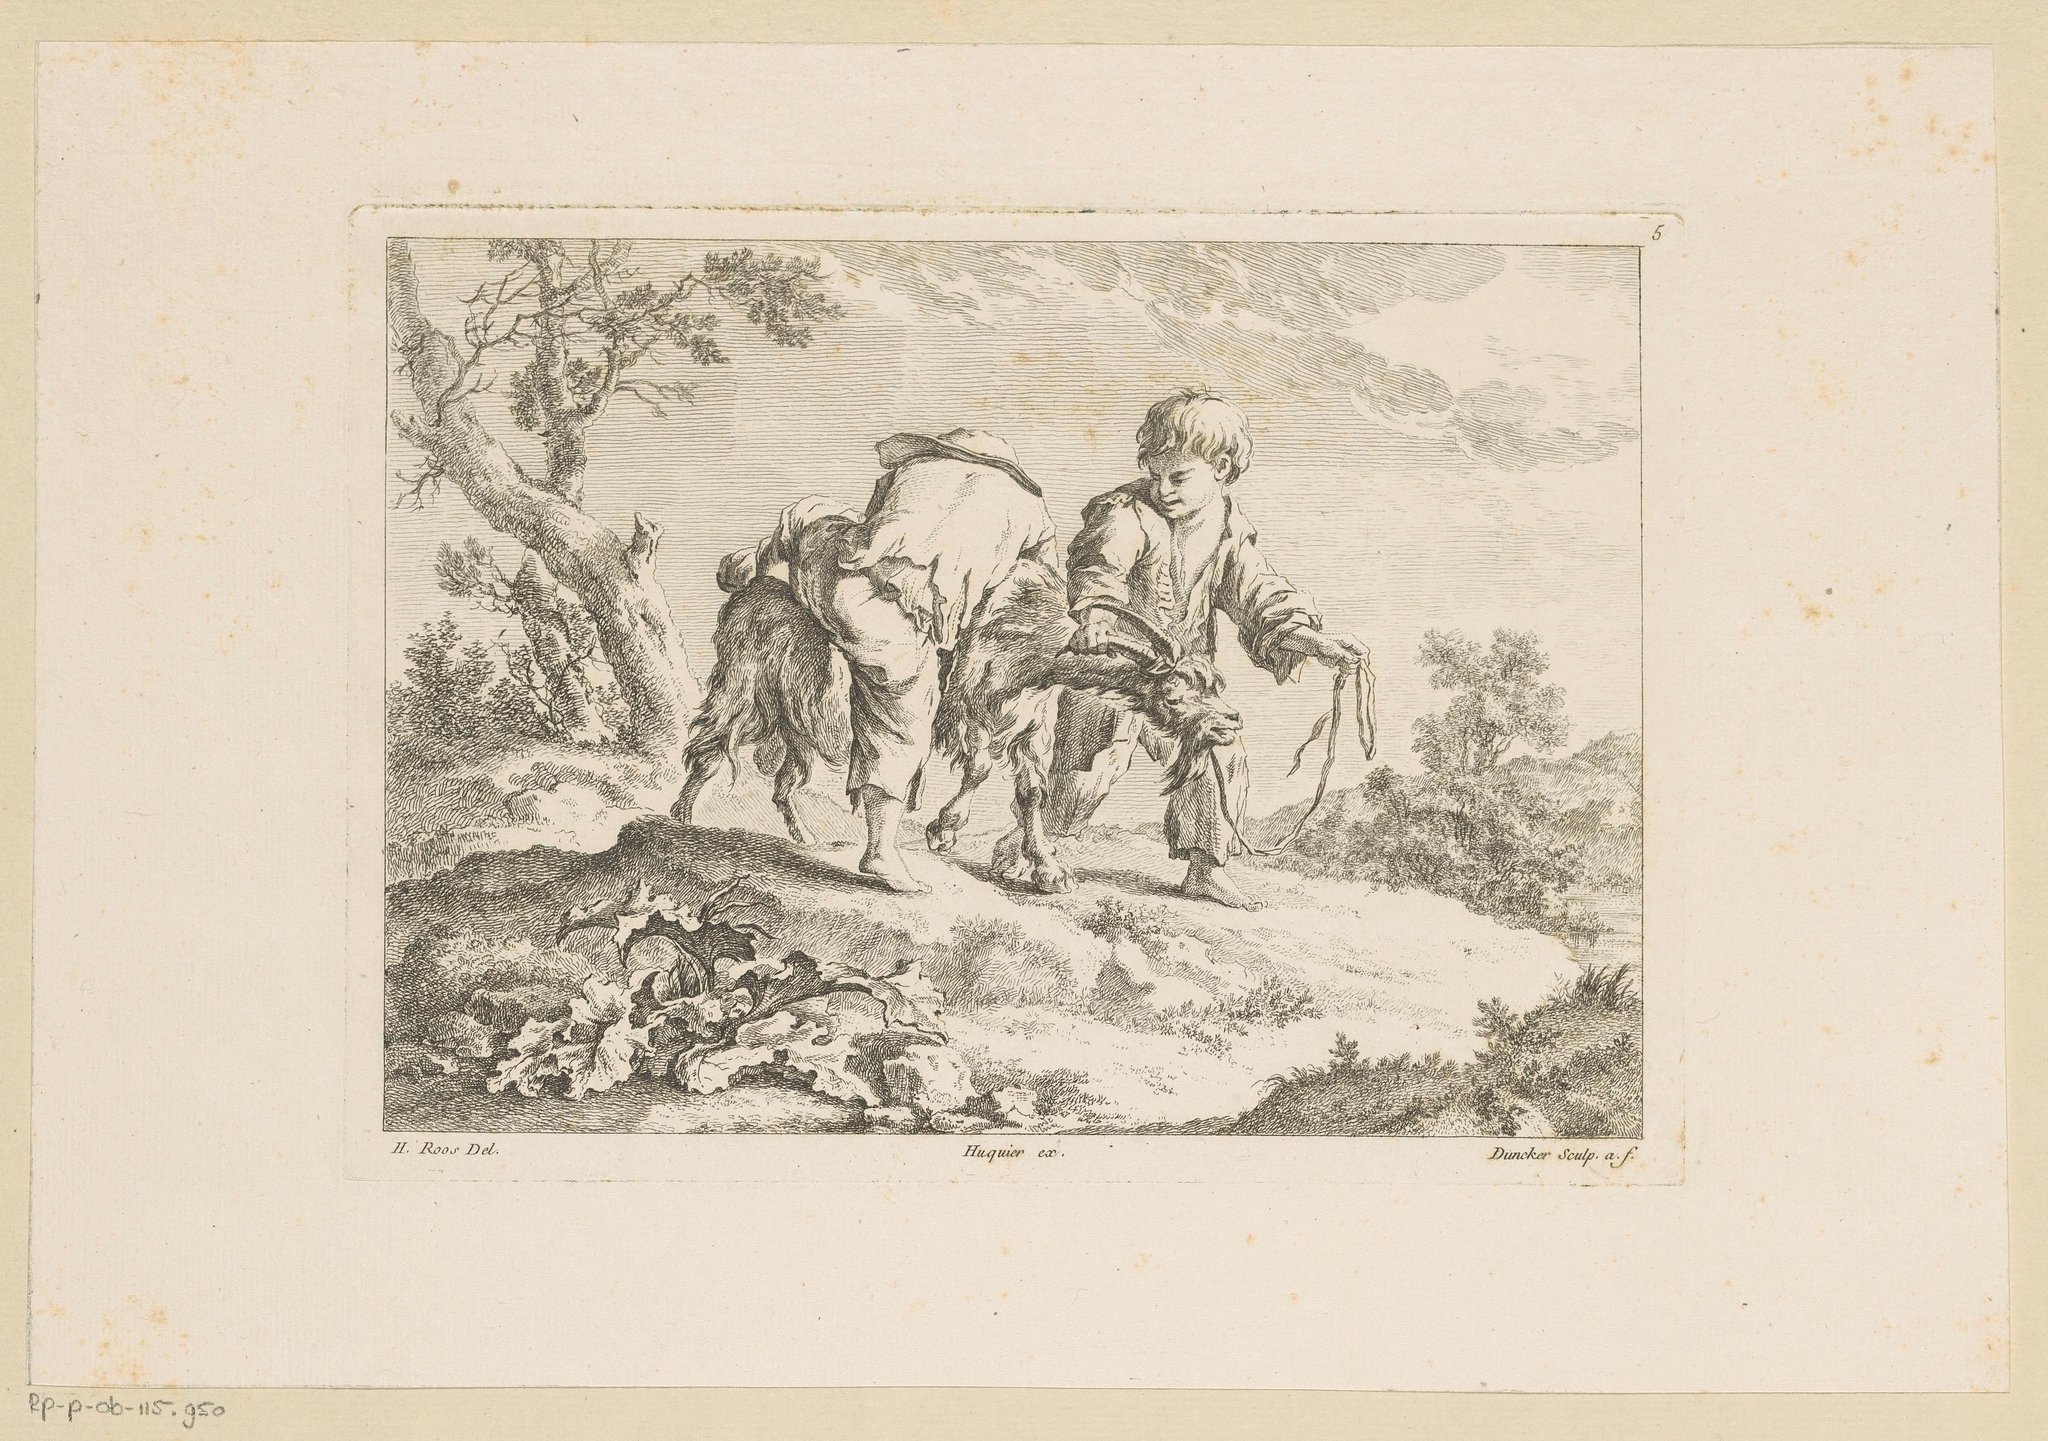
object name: print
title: Livre de differents Sujets de Figures et Animaux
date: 1769-1772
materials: paper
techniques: etching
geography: germany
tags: riding on animal other than horse, ass, or mule, he-goat, billy-goat, catching animals, landscapes - hh - ideal landscapes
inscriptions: collector's mark: Lugt 240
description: Onderdeel van een serie van acht prenten.